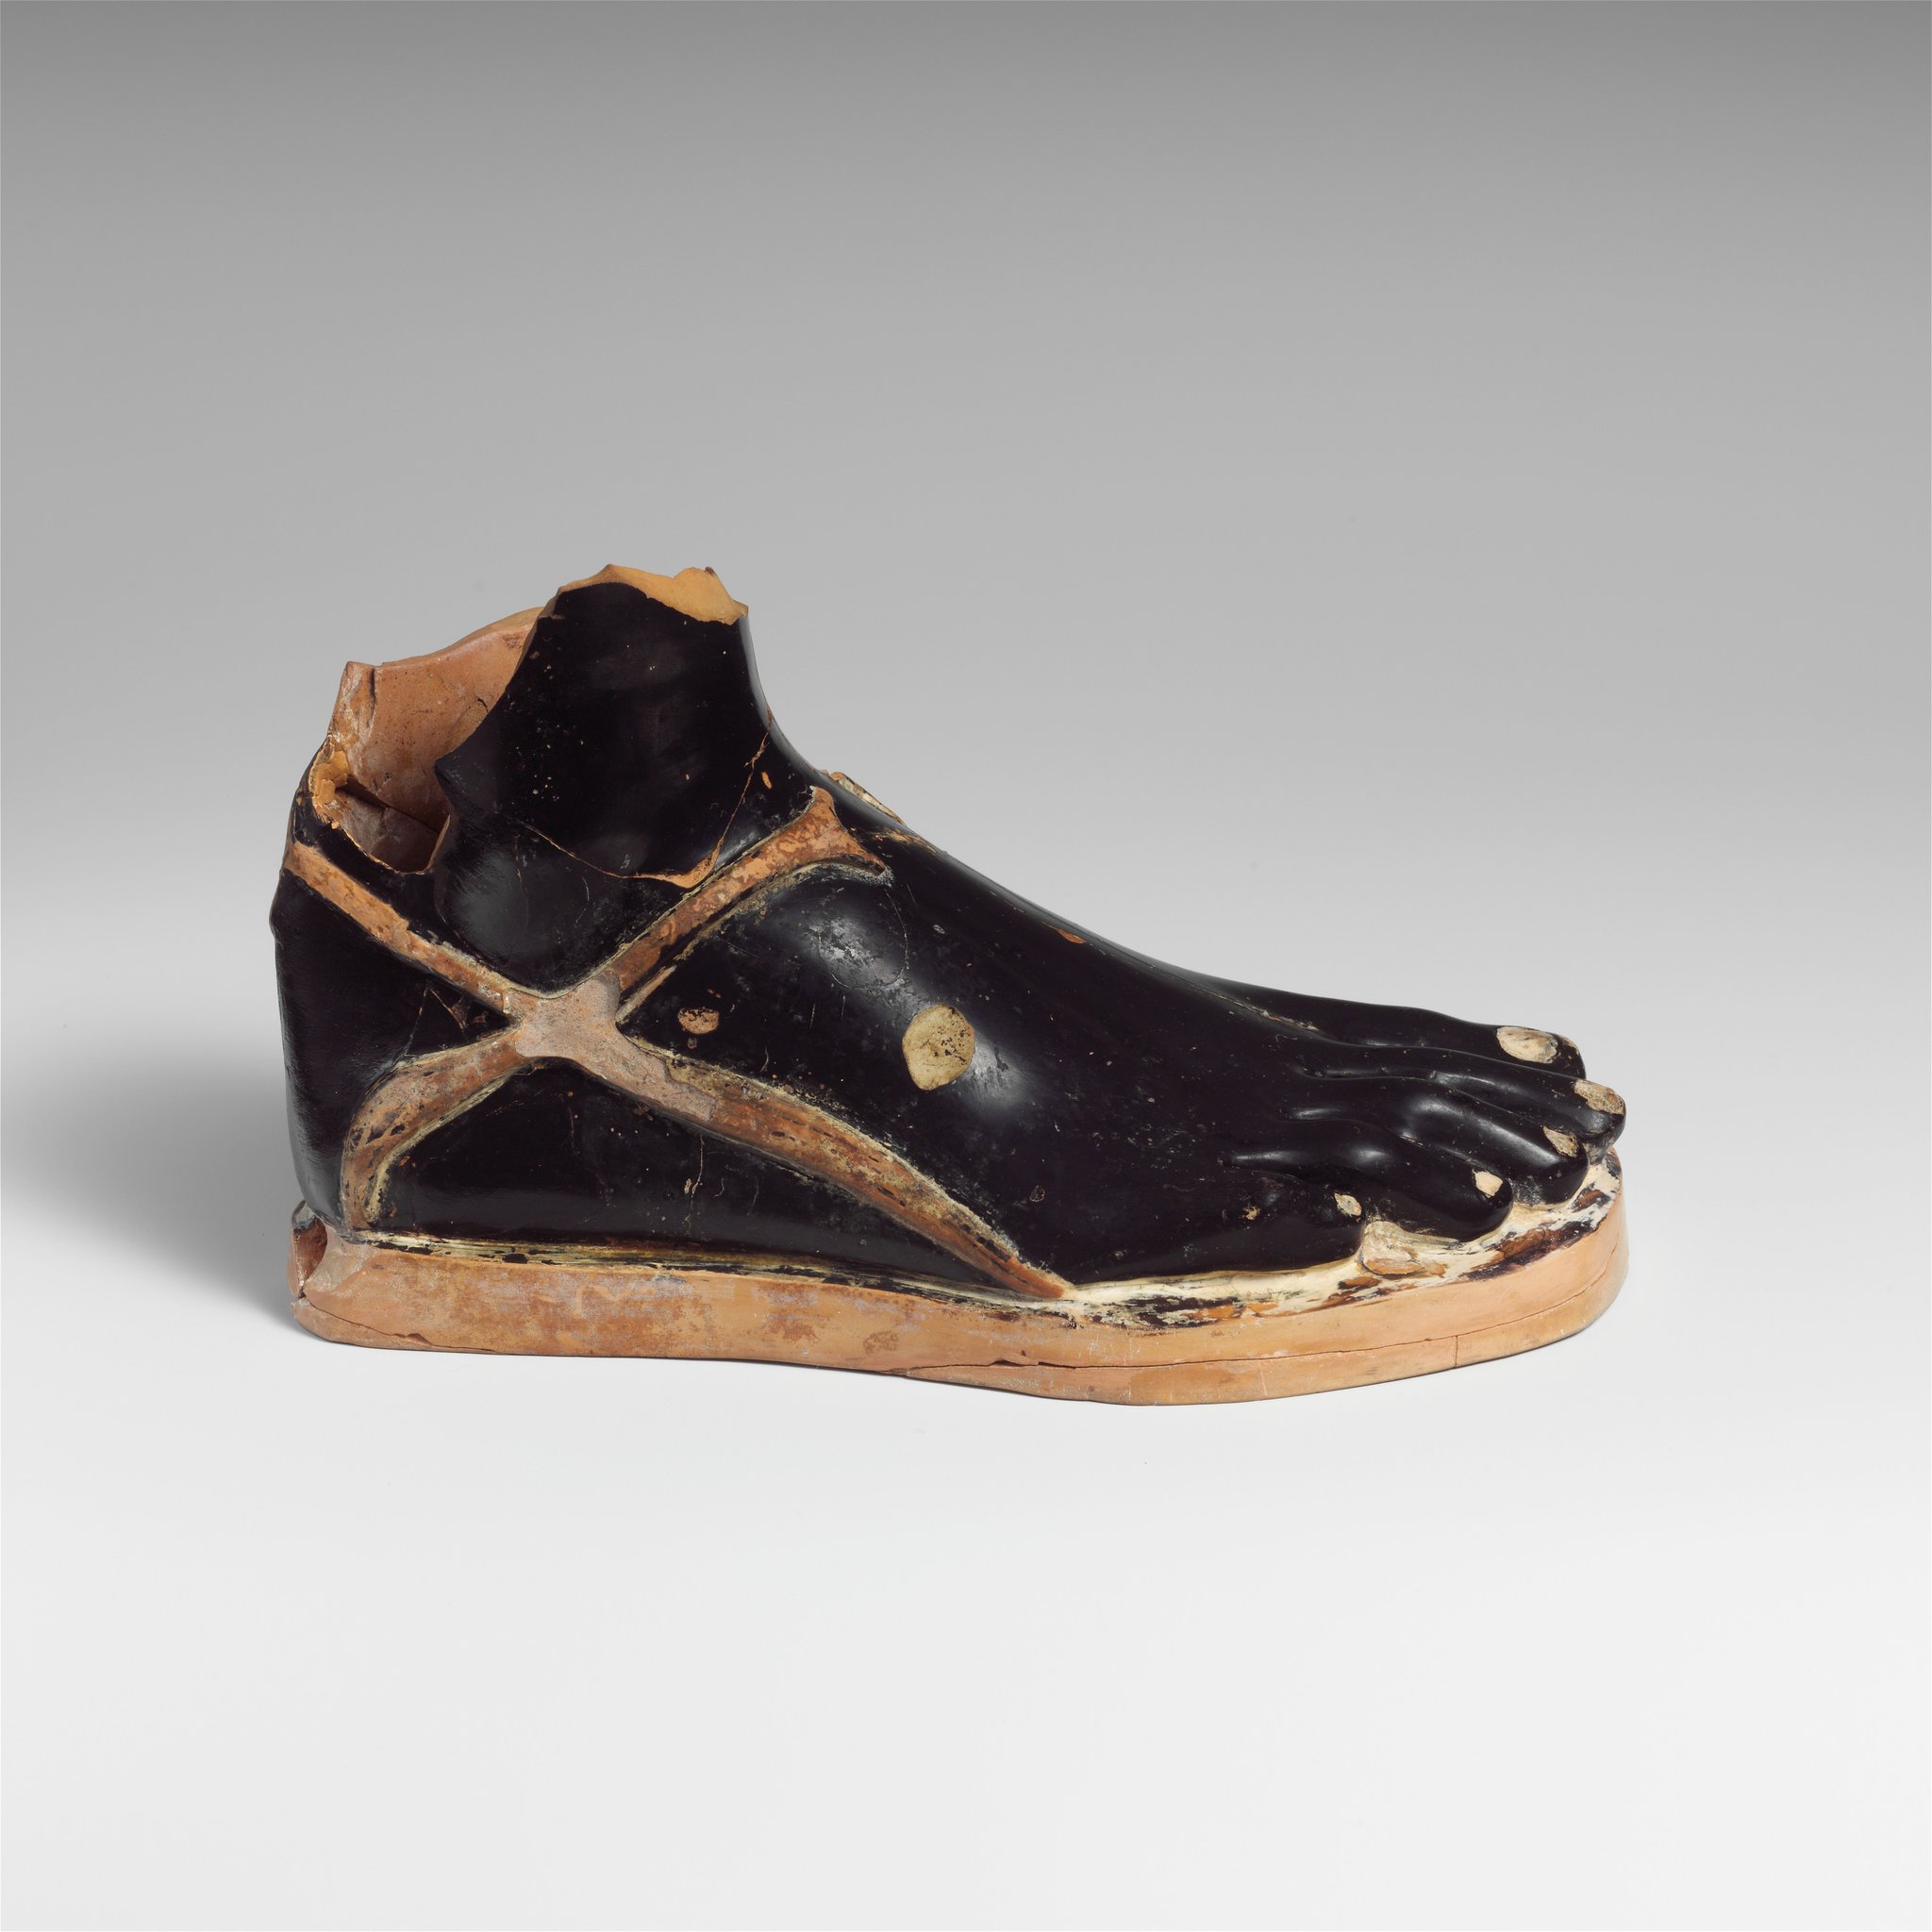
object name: vase in the form of a sandaled right foot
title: Terracotta vase in the shape of a sandaled right foot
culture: greek, attic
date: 500-451 BCE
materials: terracotta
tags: feet